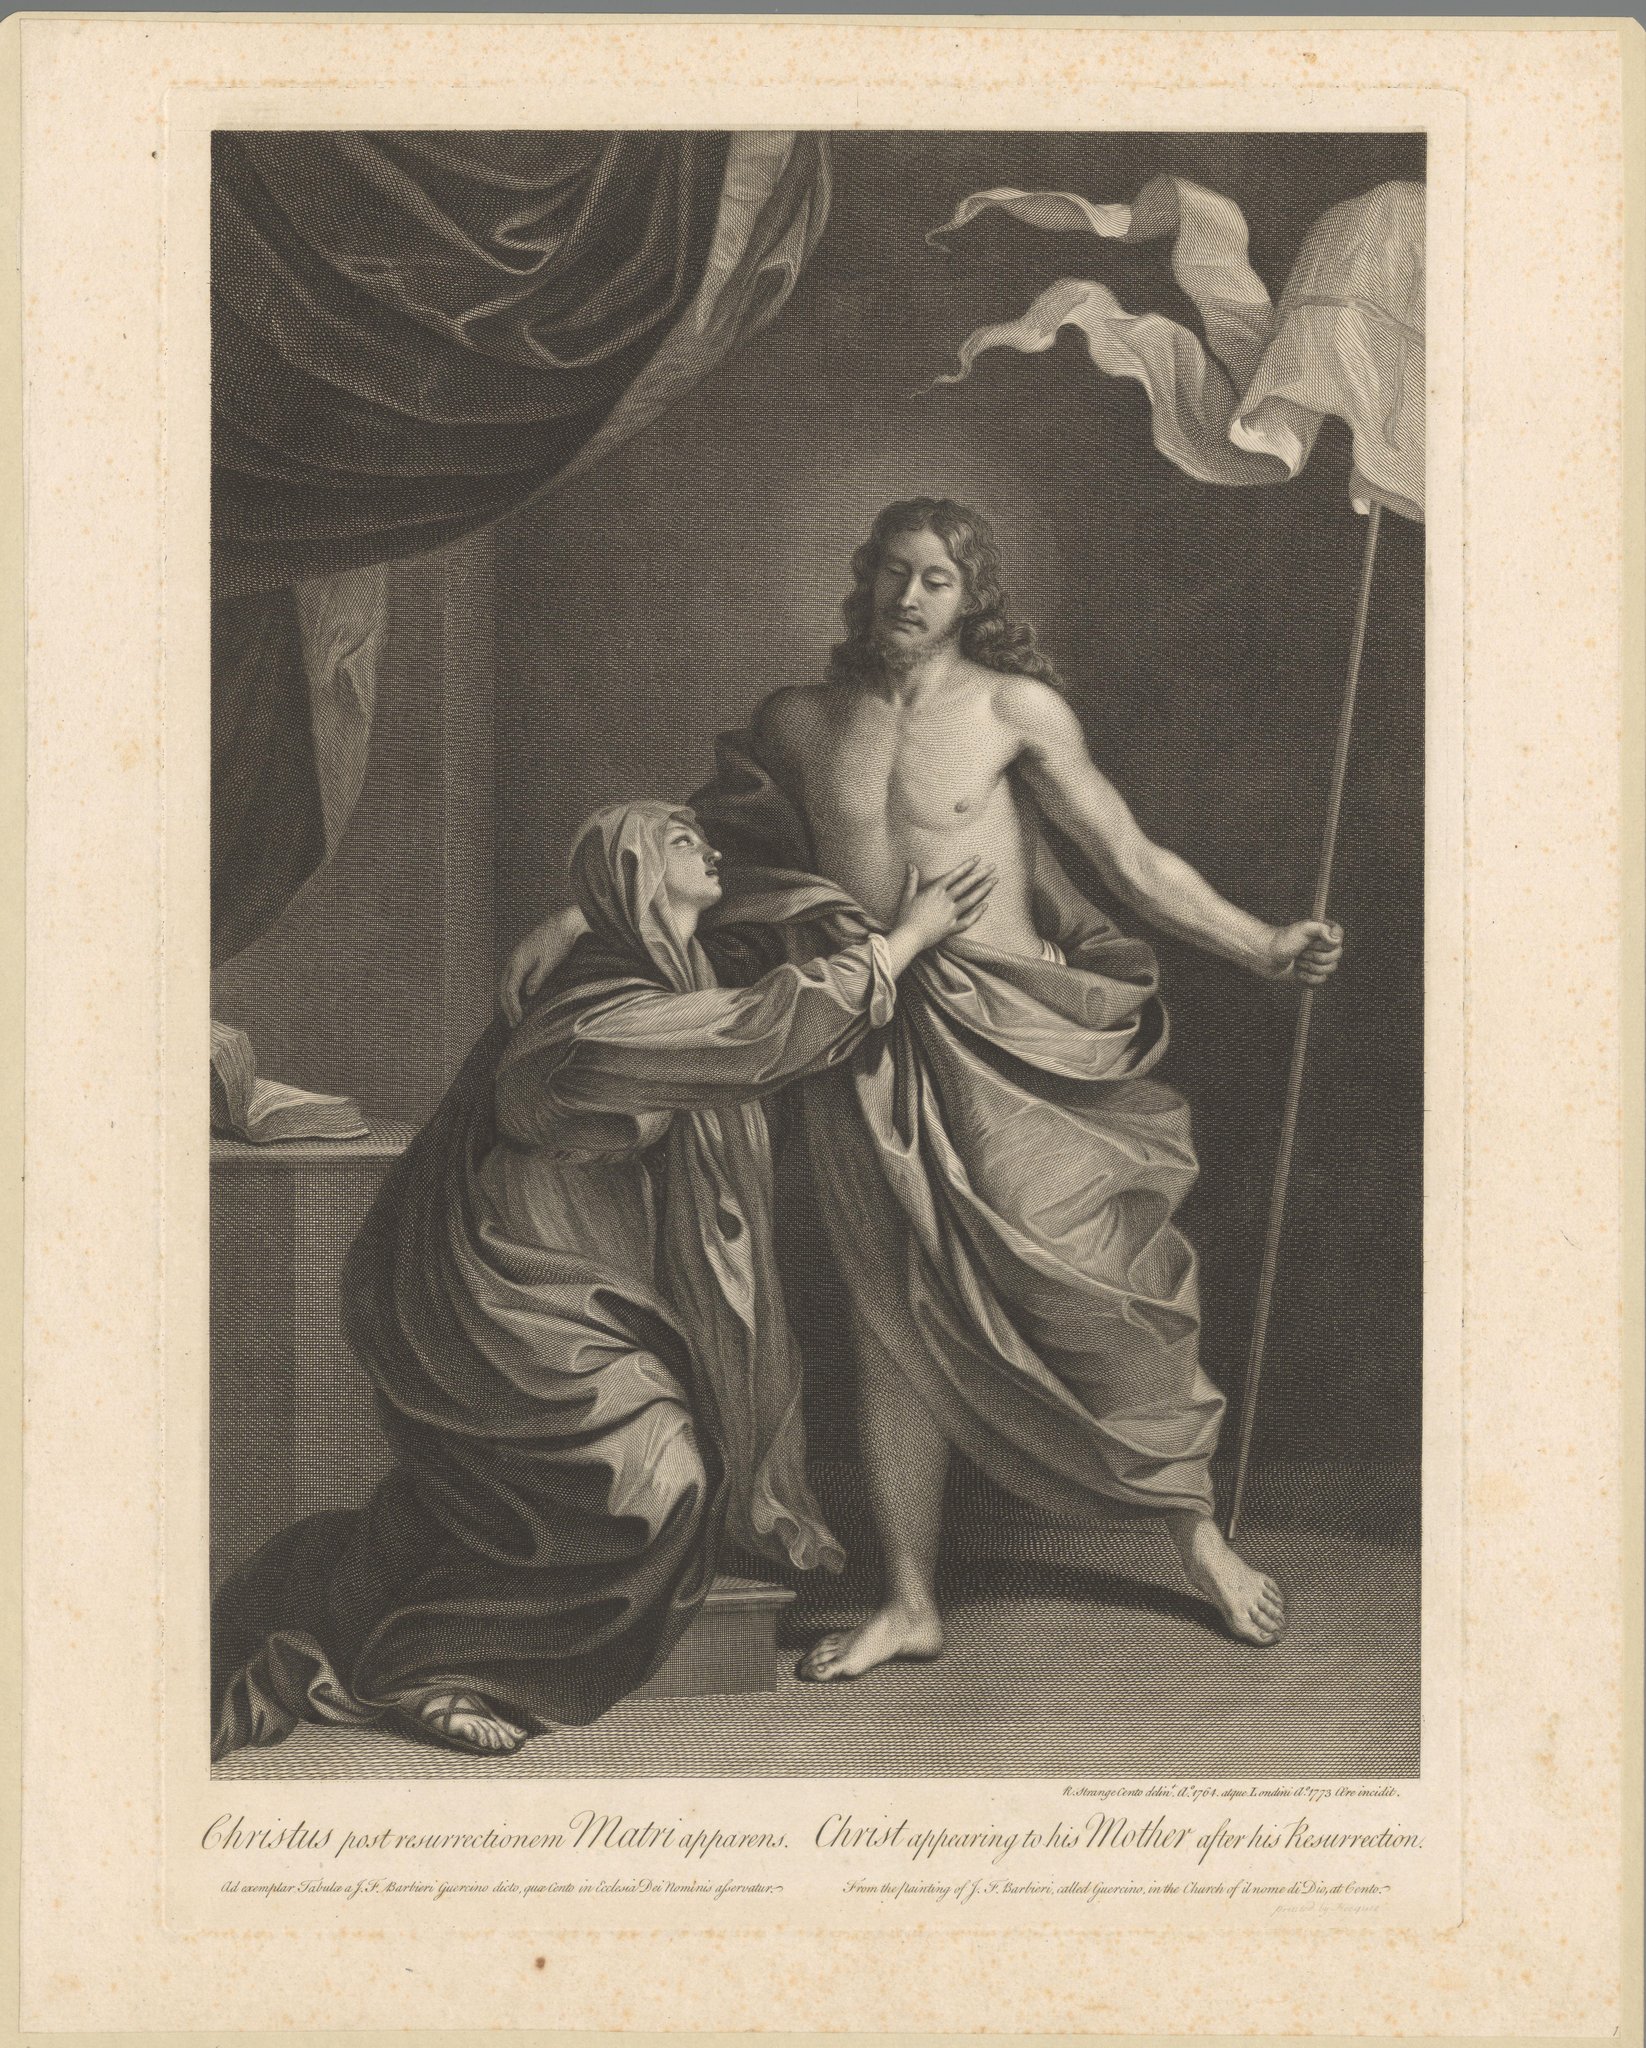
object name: print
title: Christus post resurrectionem Matri apparens / Christ appearing to his Mother after his Resurrection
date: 1773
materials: paper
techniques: engraving, etching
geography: london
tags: christ and mary embracing ~ after the resurrection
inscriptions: collector's mark: Lugt 240